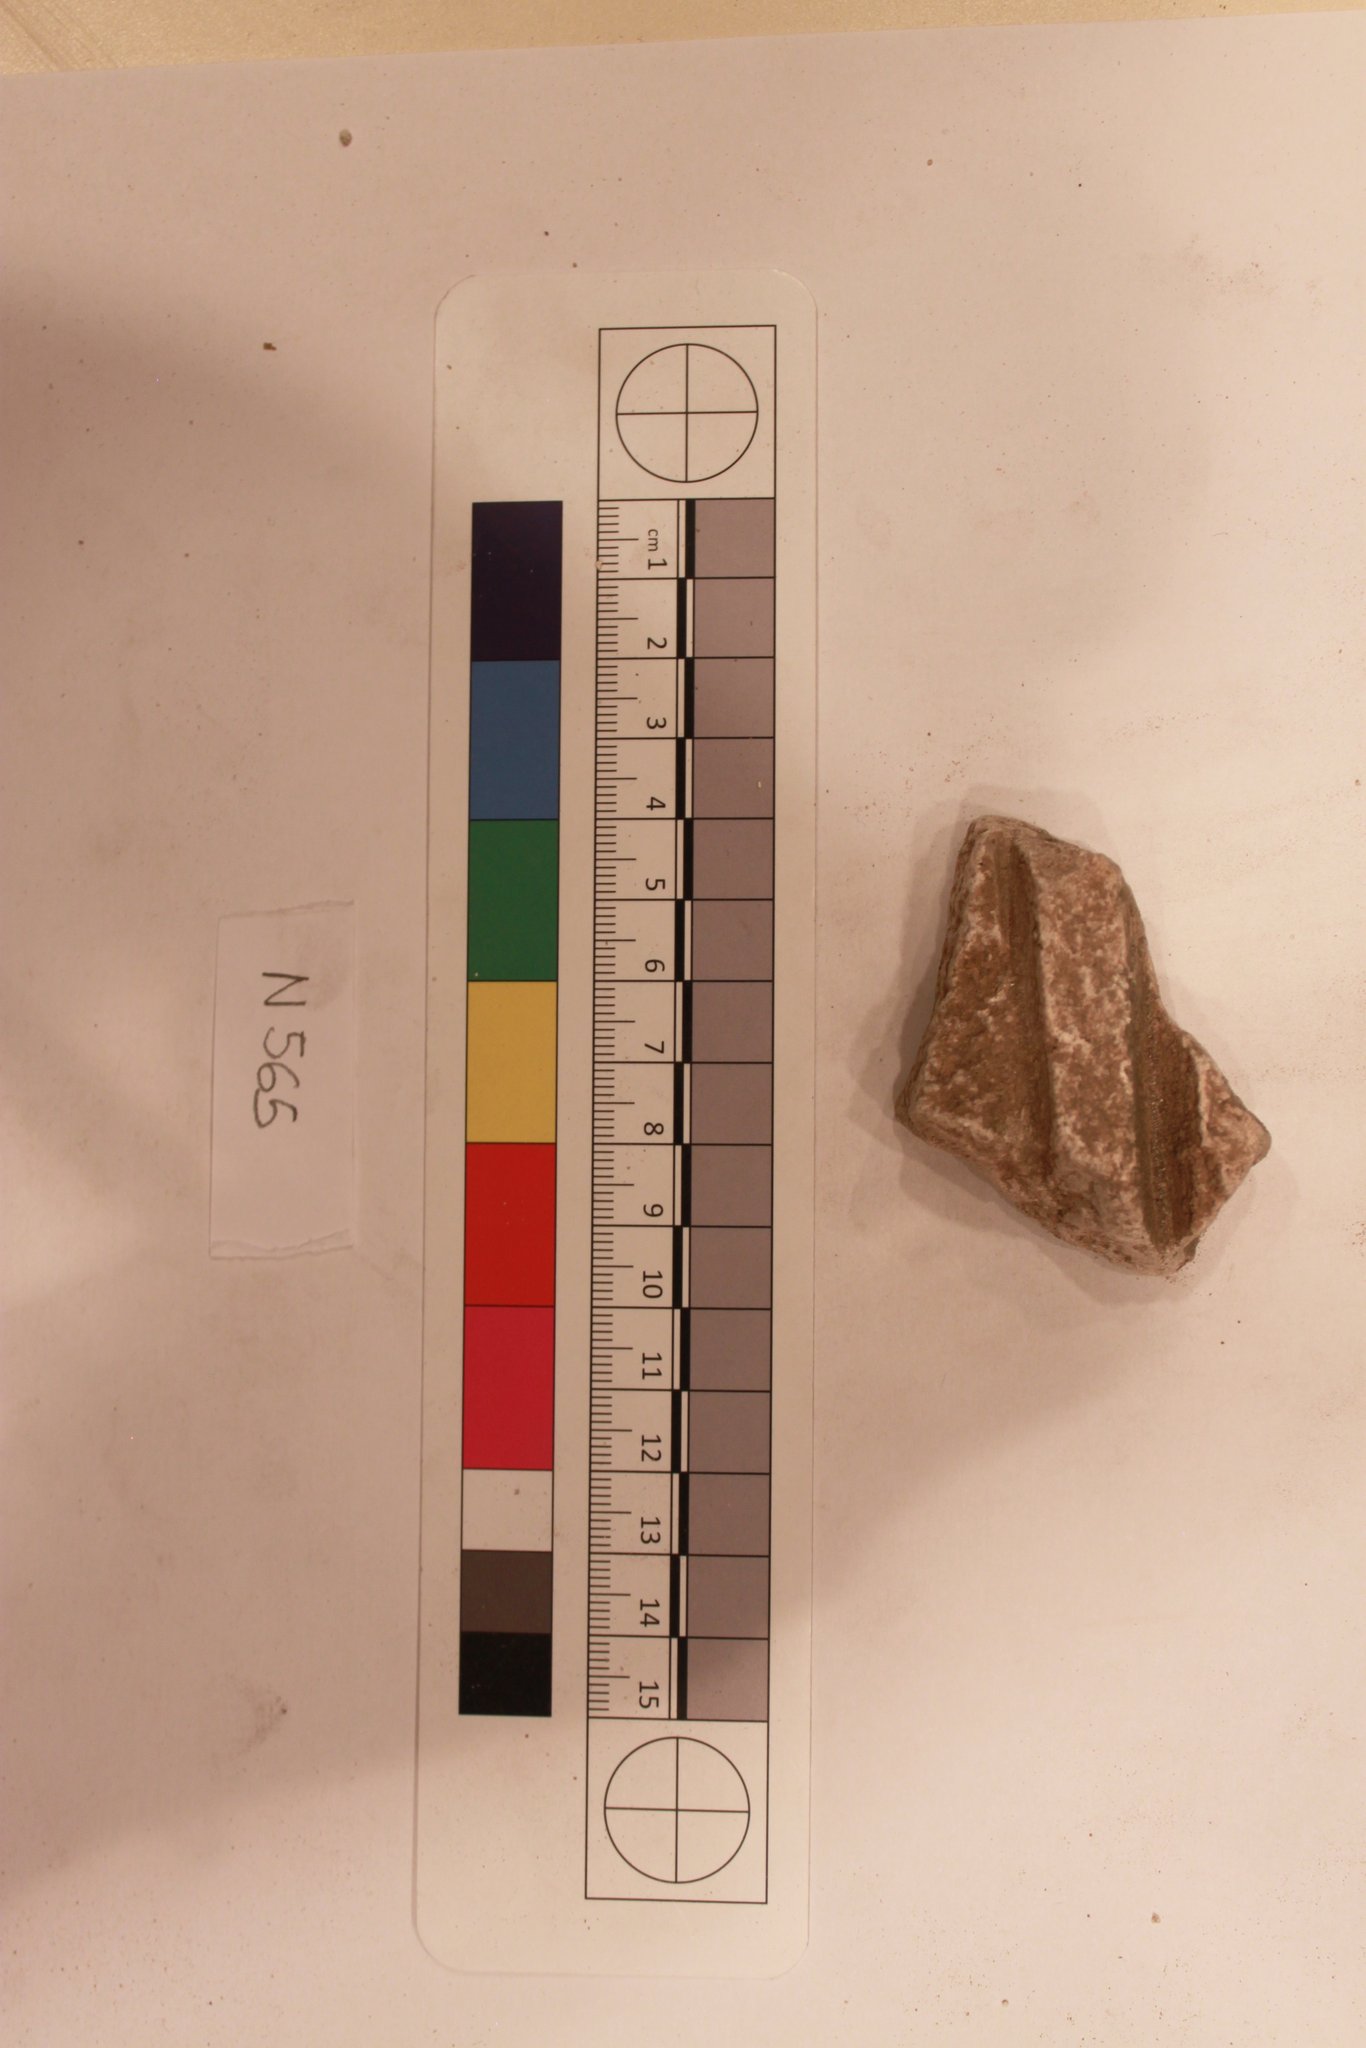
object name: fragment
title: Stucco Fragment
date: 701-1200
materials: plaster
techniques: carving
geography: iran